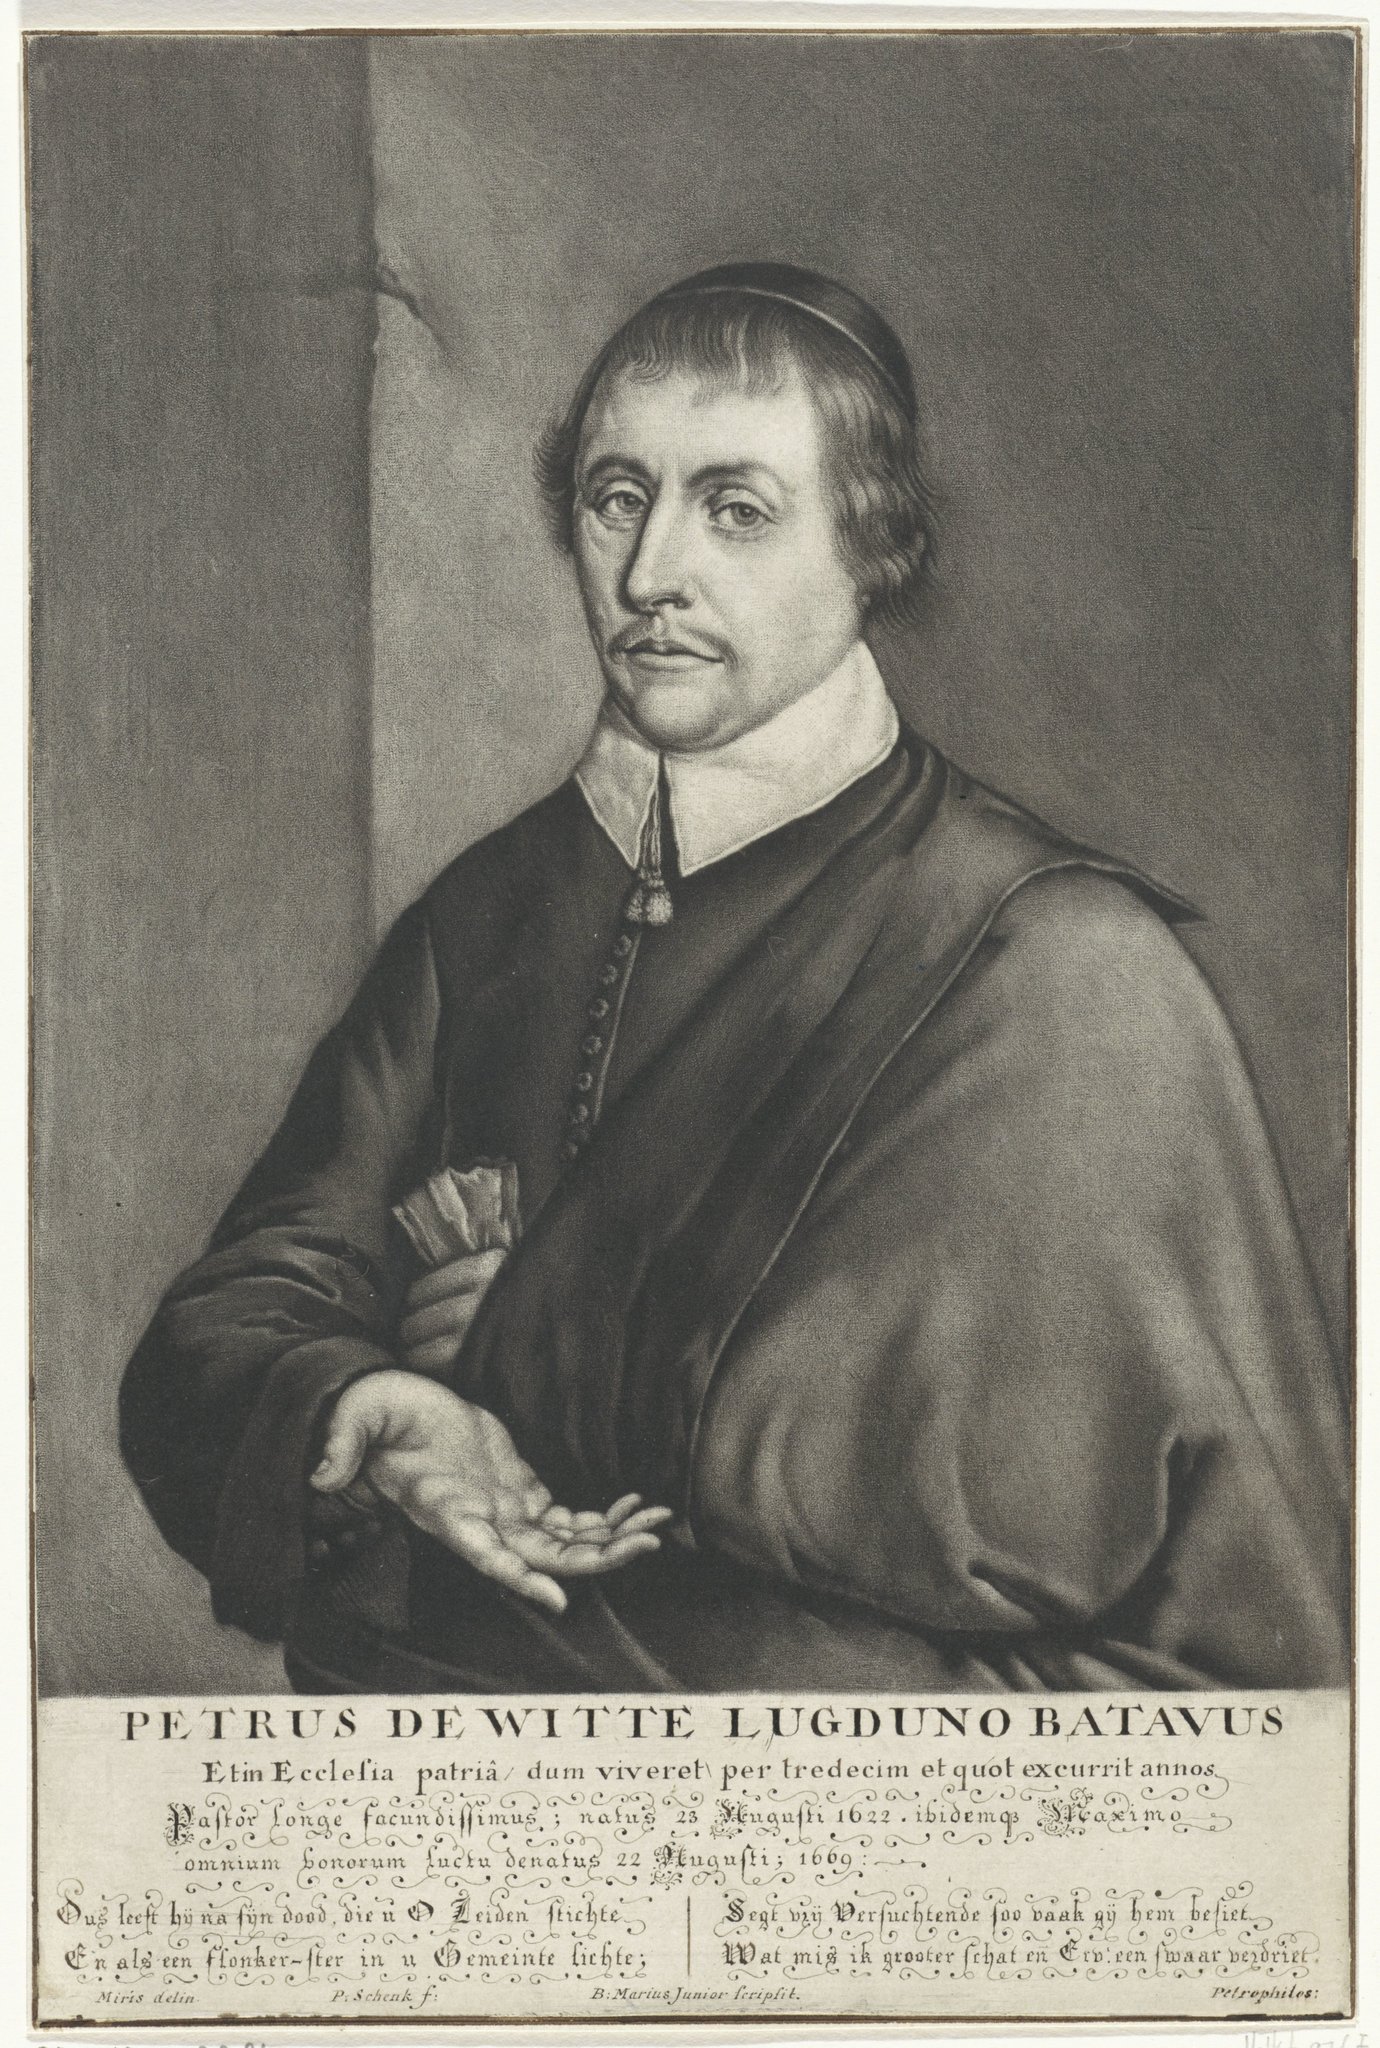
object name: print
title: Portret van Pieter de Witte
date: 1670-1713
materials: paper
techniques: pen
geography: amsterdam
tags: leiden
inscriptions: inscription: ‘Petrus De Witte [...] Petrophiles:’, collector's mark: Lugt 2228